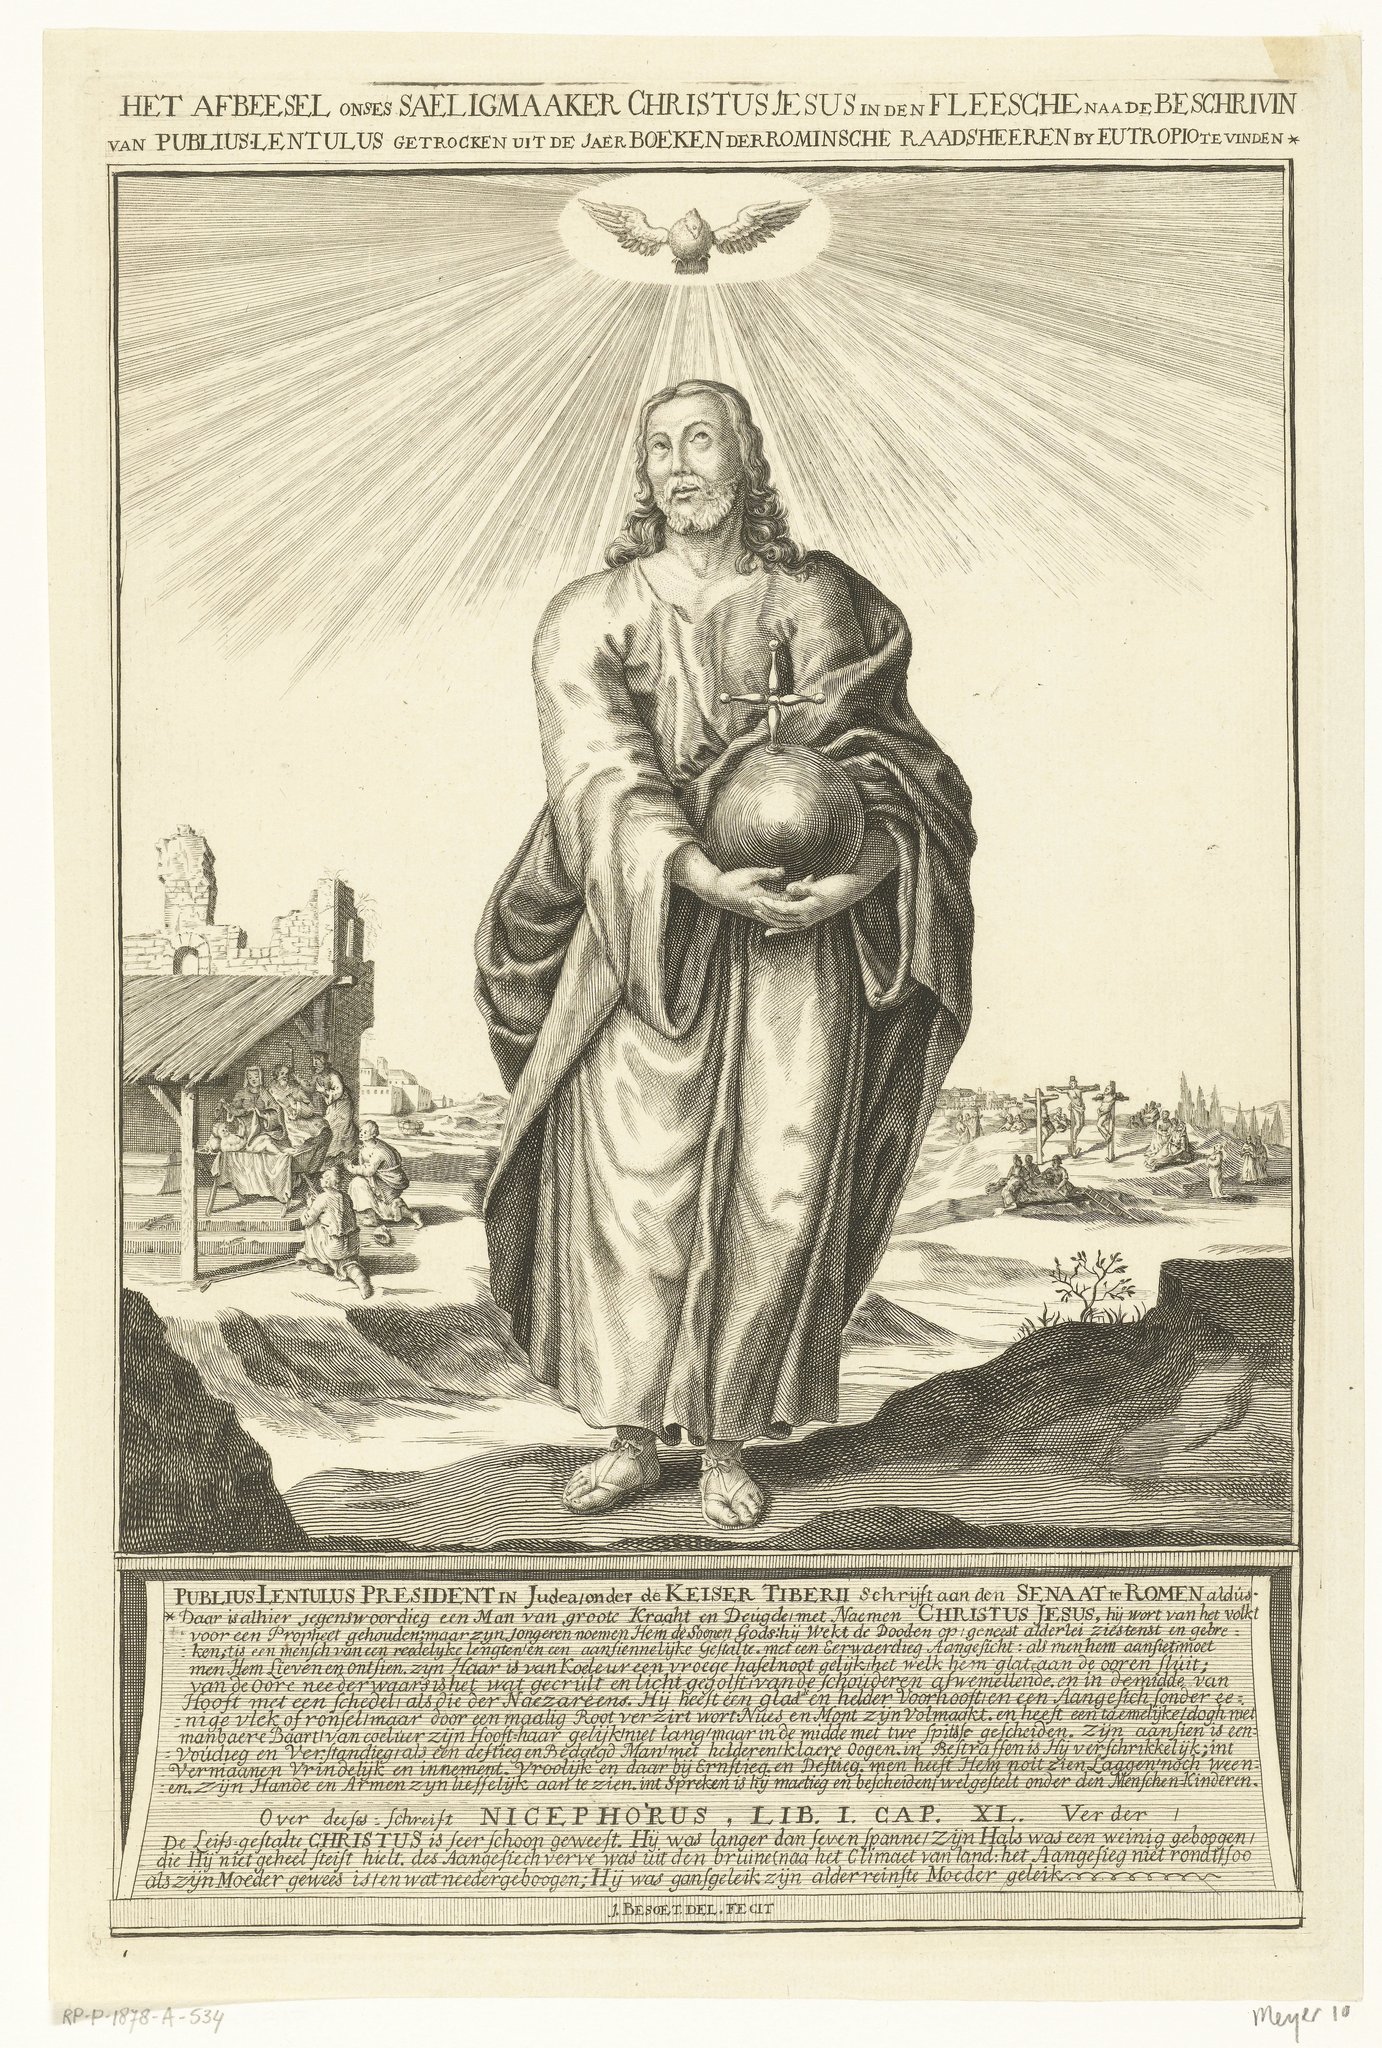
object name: print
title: Staande Christus met rijksappel en H. Geest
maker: iven besoet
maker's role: print maker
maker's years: 1720-1769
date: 1730-1769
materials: paper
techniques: engraving, etching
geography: netherlands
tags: adoration of the christ-child by the shepherds; mary and joseph present, 'salvator mundi', making a blessing gesture; an orb in his hand or at his feet, 'portrait' of christ according to the letter of lentulus, the crucifixion of christ: christ's death on the cross; golgotha (matthew 27:45-58; mark 15:33-45; luke 23:44-52; john 19:25-38), holy ghost represented as a dove (in flames)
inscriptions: collector's mark: Lugt 2228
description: Christus met rijksappel in handen staand in landschap en en duif als symbool van Heilige Geest boven zijn hoofd. In het landschap zijn twee scènes weergegeven die verwijzen naar het begin en het einde van het leven van Christus: de aanbidding van het Christuskind door de herders en de kruisiging van Christus op berg Golgotha met Maria treurend bij het kruis. Onder de voorstelling staat een citaat uit een apocriefe brief van Publius Lentulus aan de Romeinse Senaat over Christus.